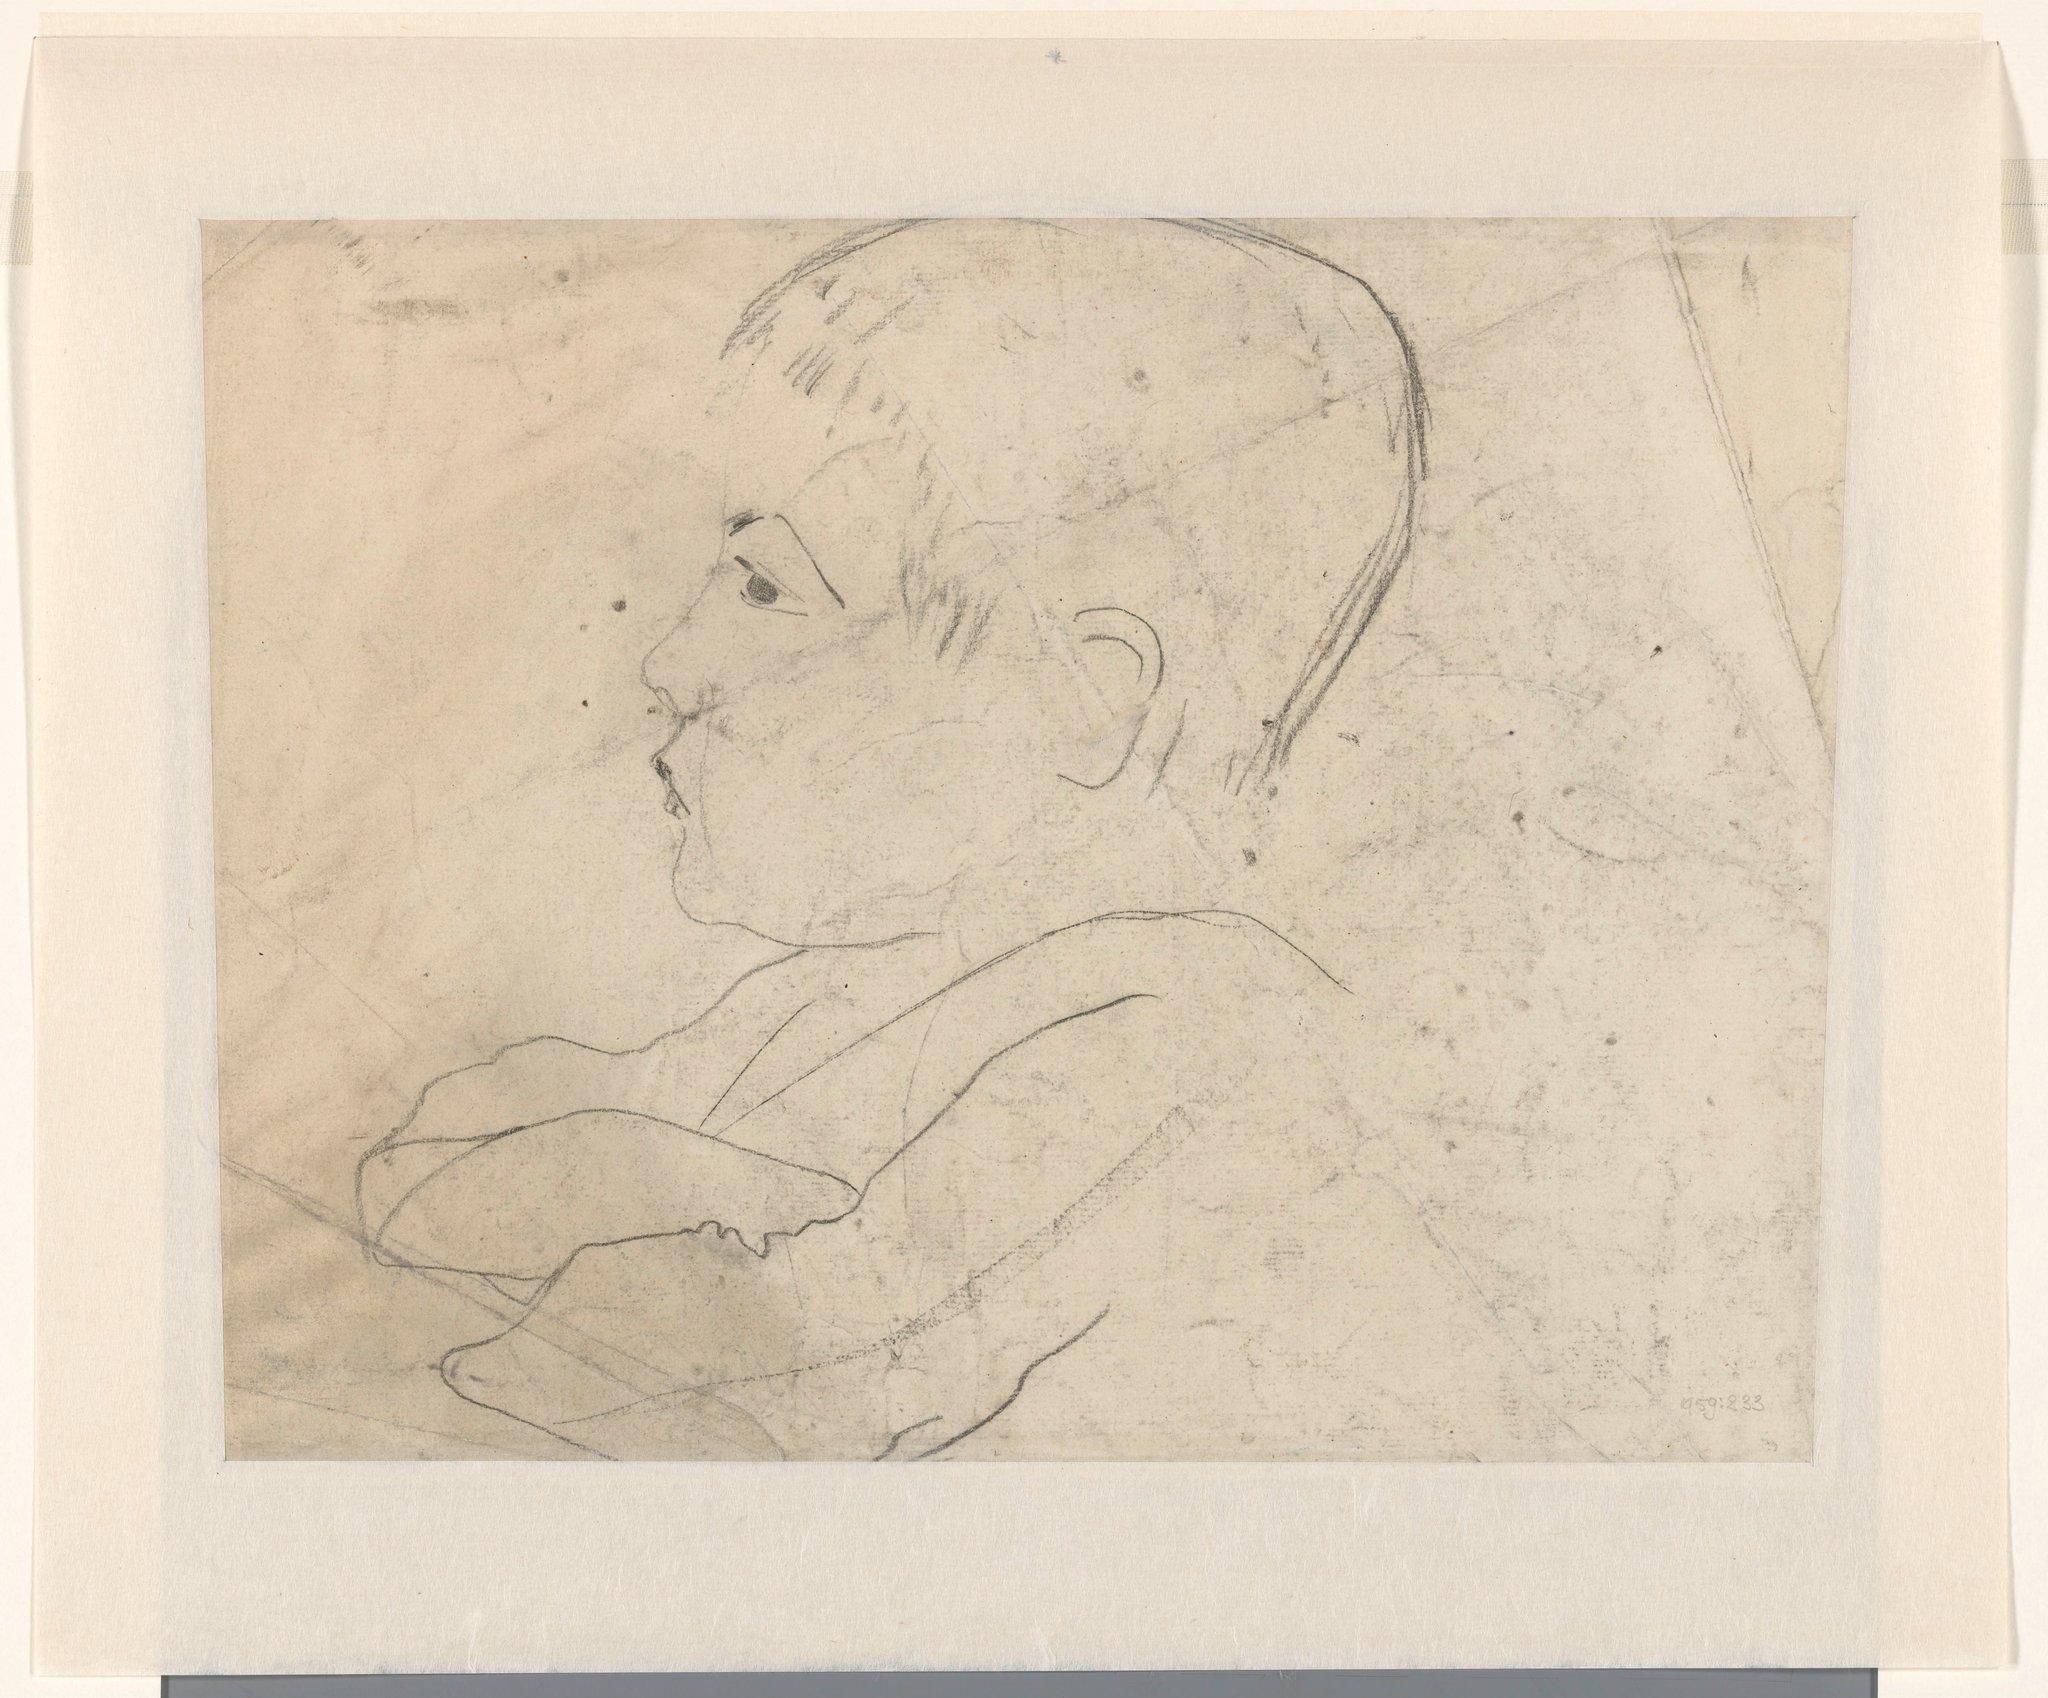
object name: drawing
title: Jongenskop, en profil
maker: carel adolph lion cachet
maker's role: draughtsman, print maker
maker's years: 1864-1945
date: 1874-1945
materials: chalk, paper